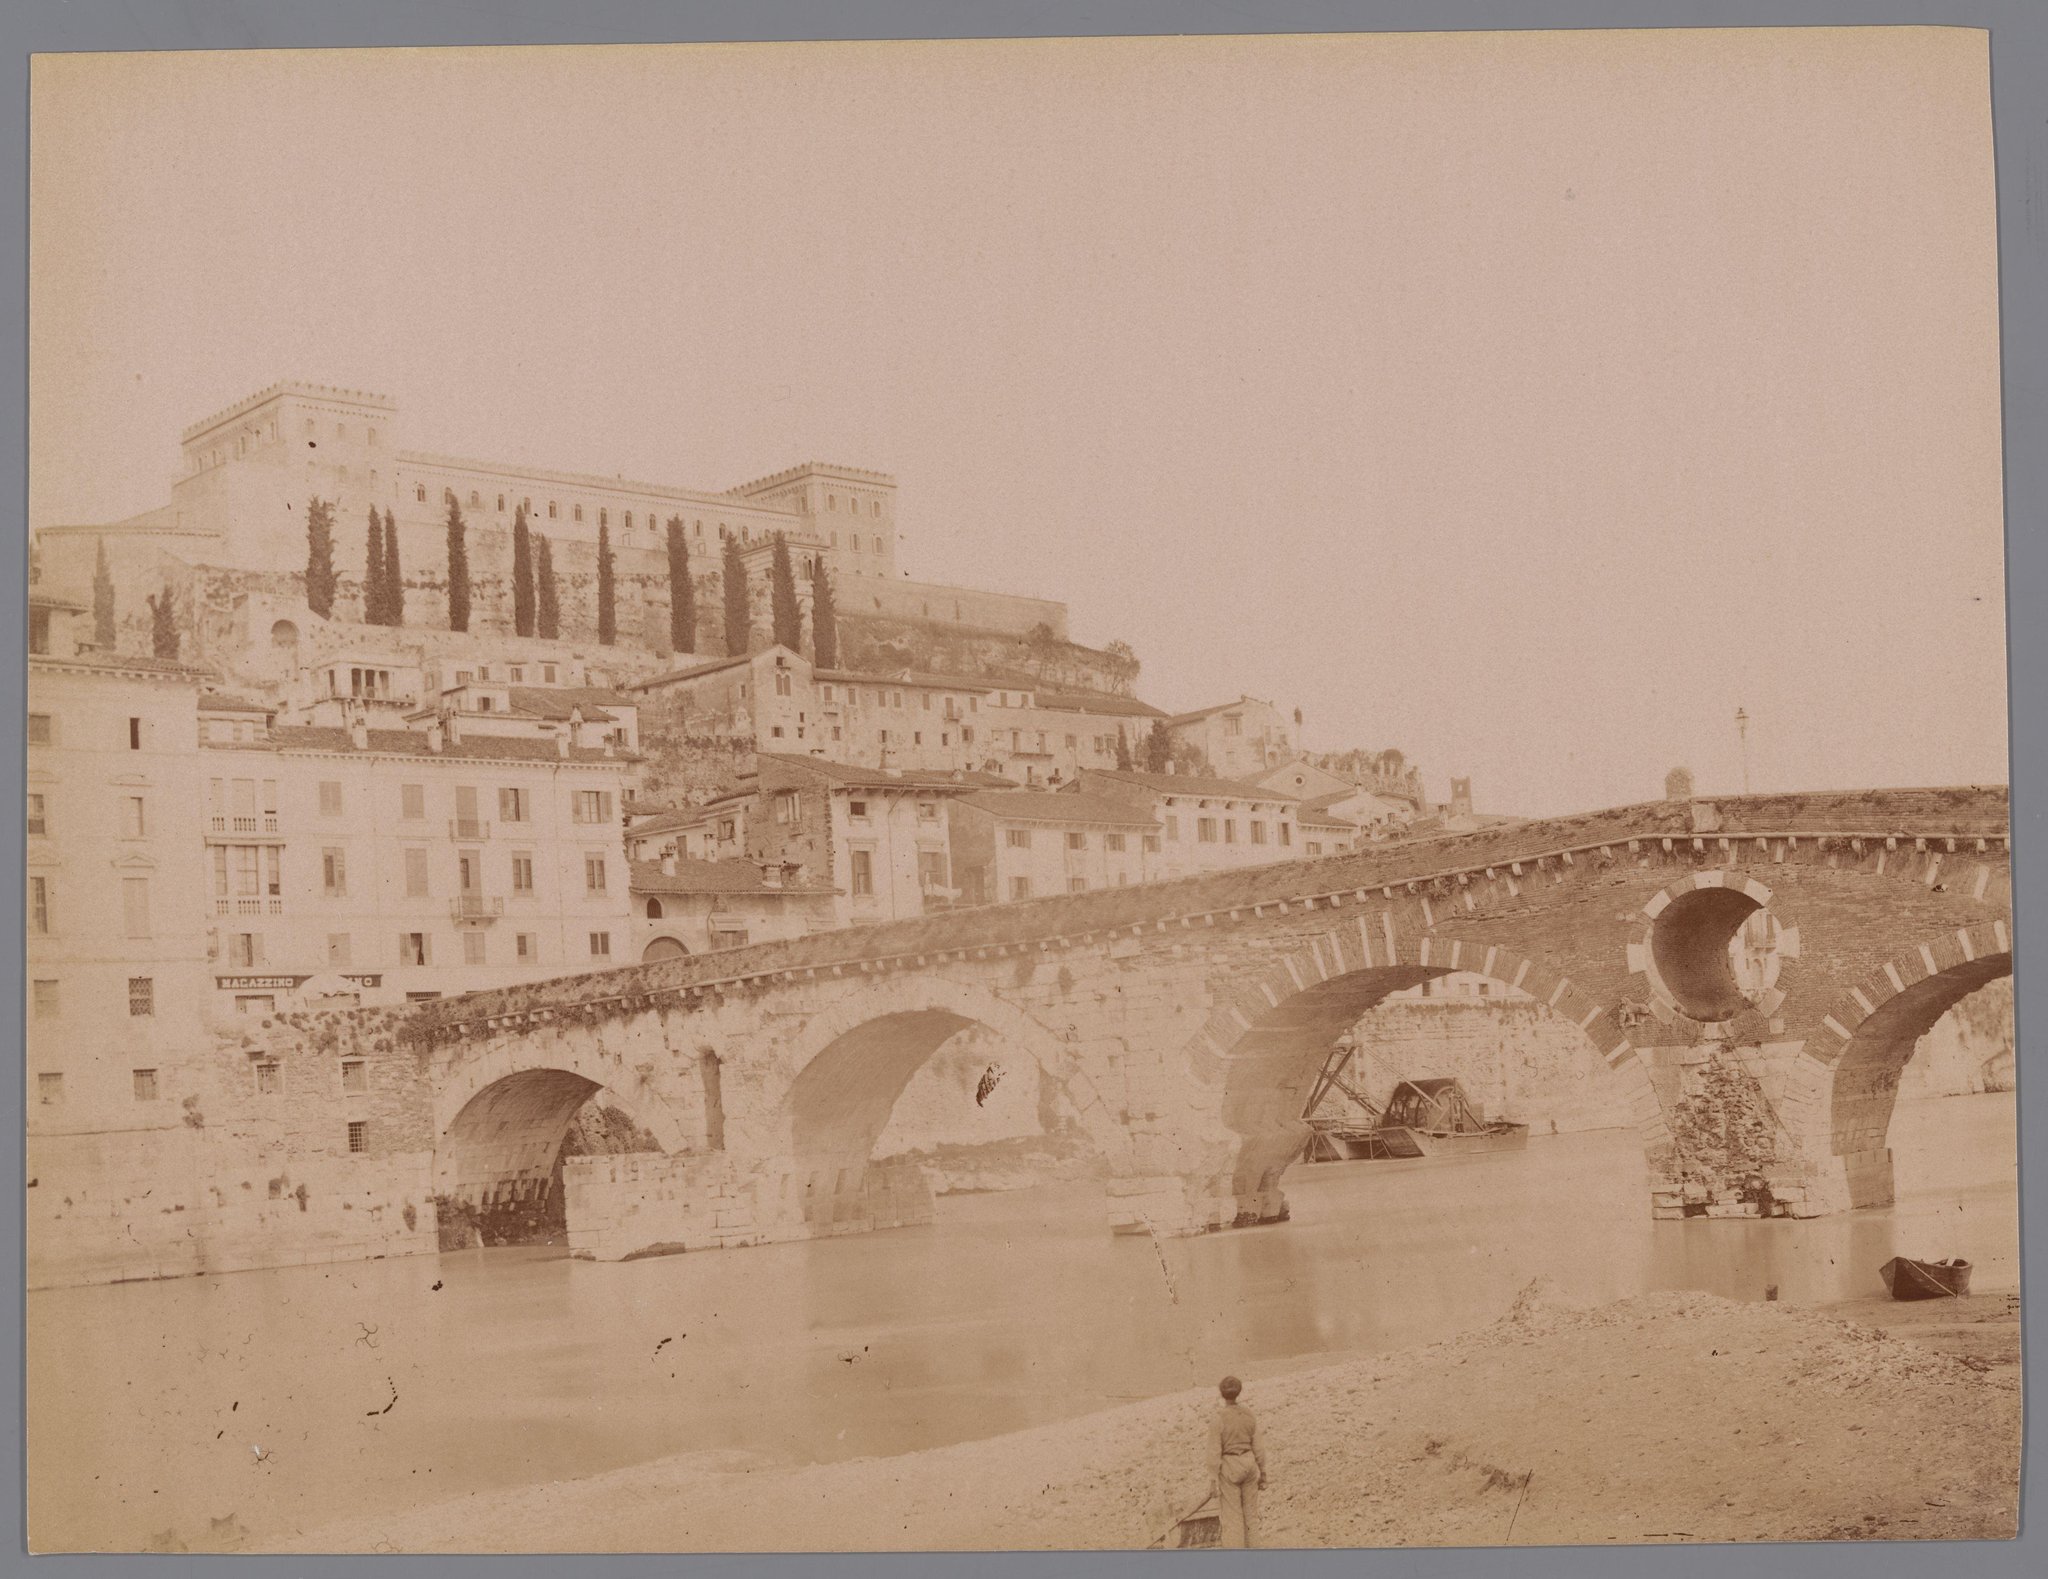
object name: photograph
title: Verona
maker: Anonymous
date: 1851-1900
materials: paper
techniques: albumen print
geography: verona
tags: landscape with bridge, viaduct or aqueduct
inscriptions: collector's mark: ‘VOSMAER’